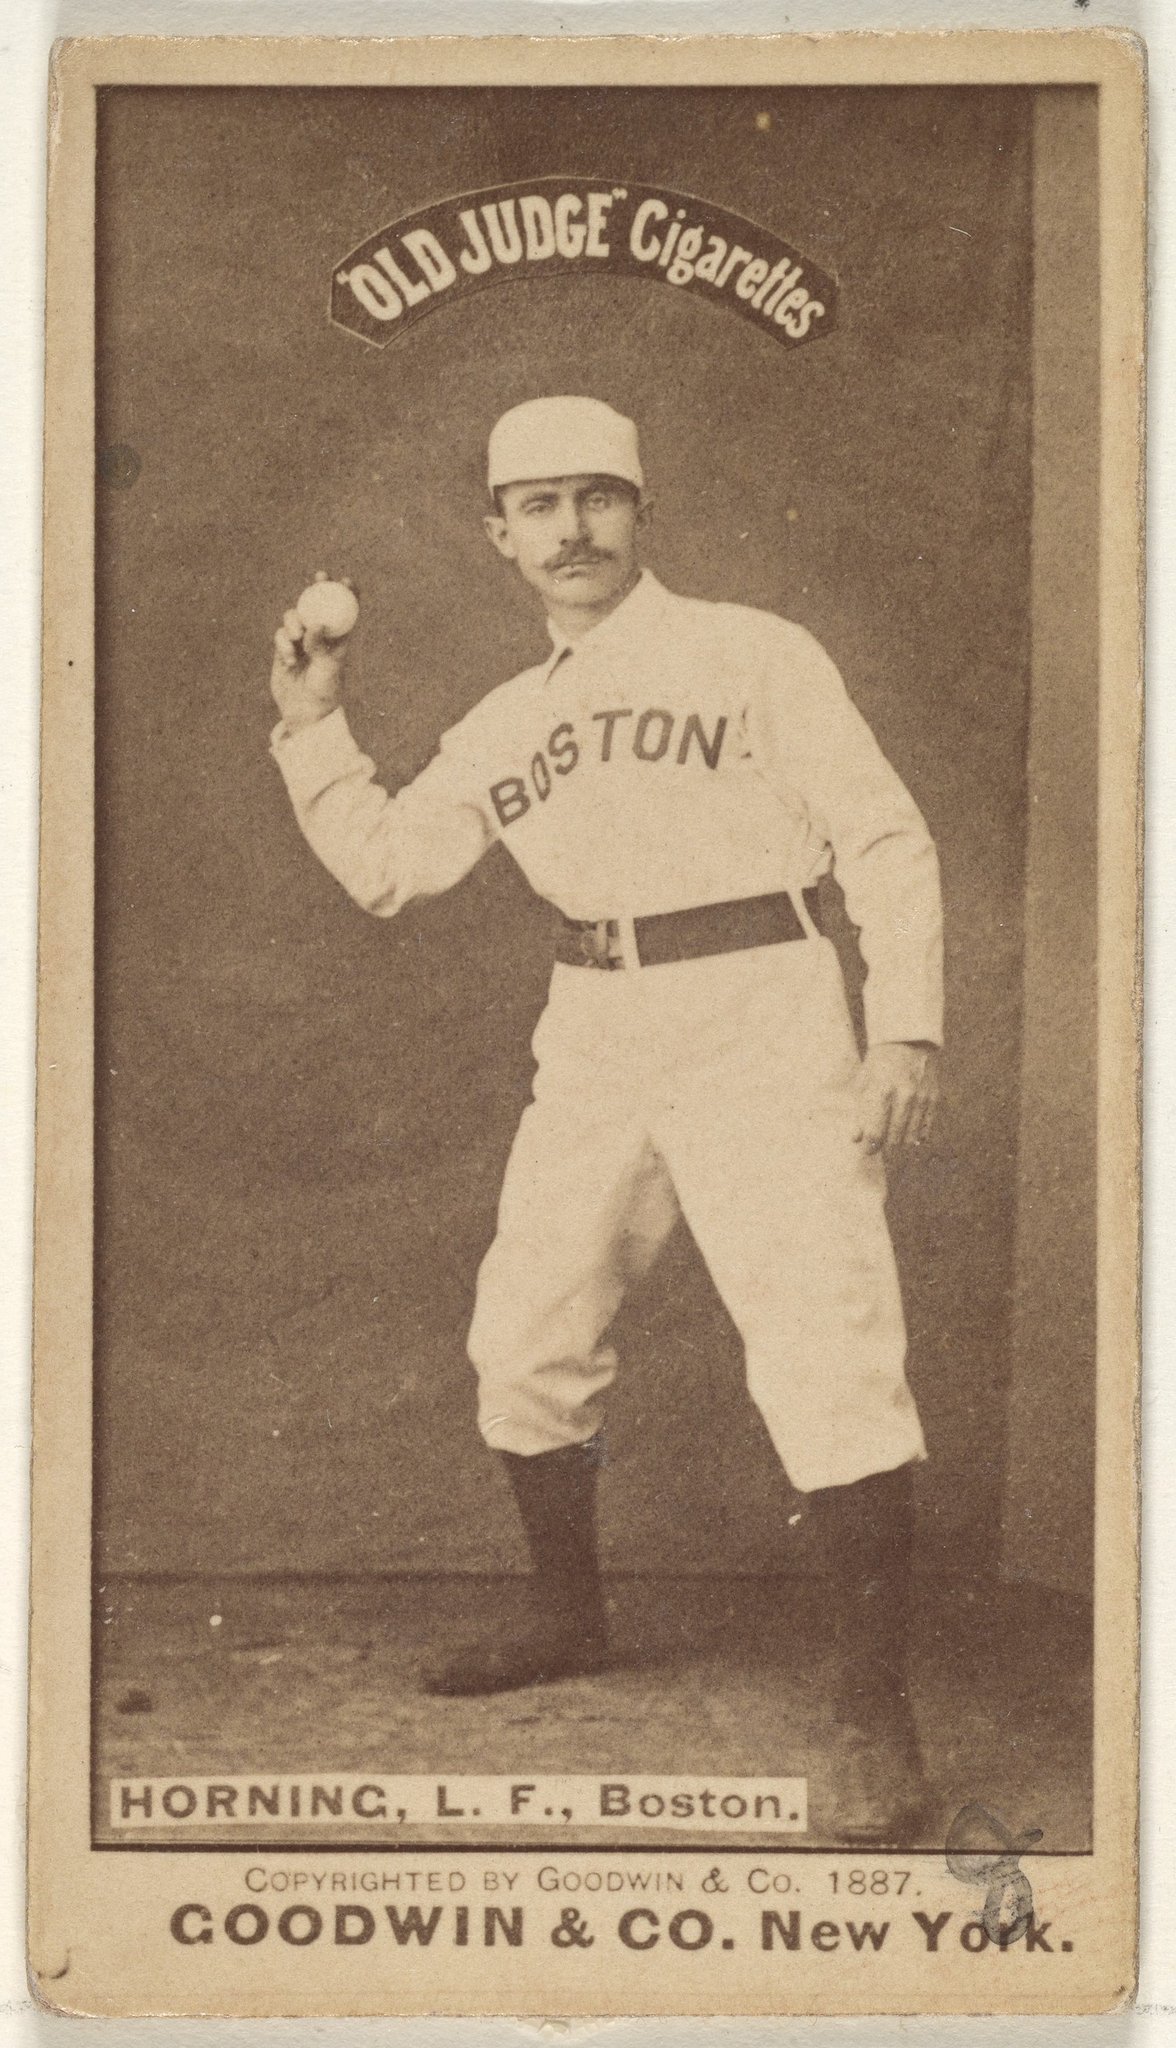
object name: baseball card, photograph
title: Horning, Left Field, Boston, from the Old Judge series (N172) for Old Judge Cigarettes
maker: goodwin & company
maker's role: publisher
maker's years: 1850-1950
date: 1887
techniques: albumen silver print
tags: men,portraits,baseball,athletes